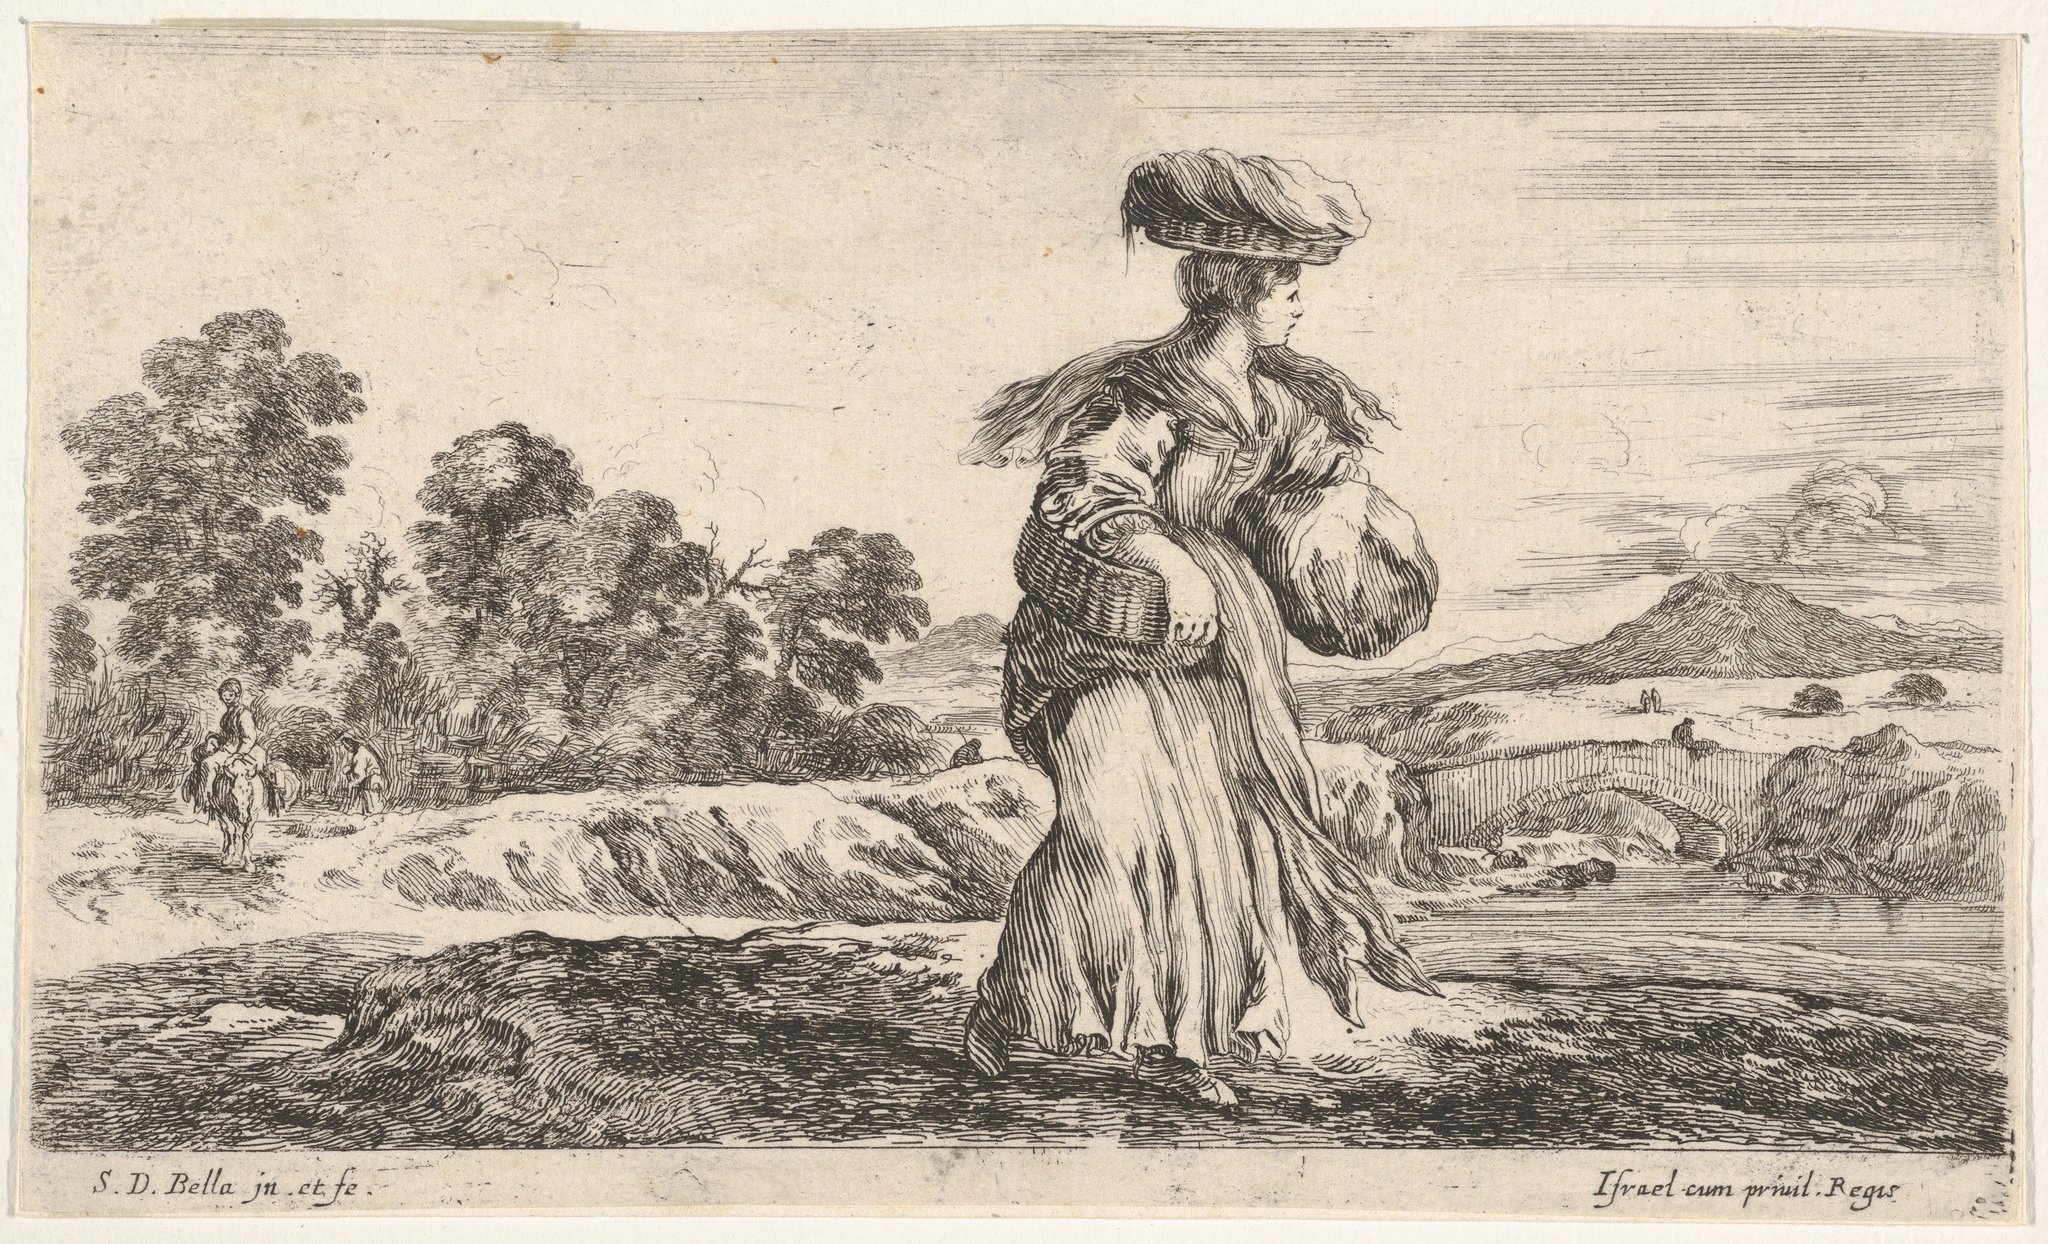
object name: print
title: A peasant woman, standing in center facing right, carrying one basket on her head and another in her right arm, another peasant woman on a donkey and a figure on foot to left in the background, from "Various figures and lands" (Diverse figure e paesi)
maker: stefano della bella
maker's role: artist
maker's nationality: italian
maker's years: 1610-1664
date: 1649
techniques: etching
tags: women